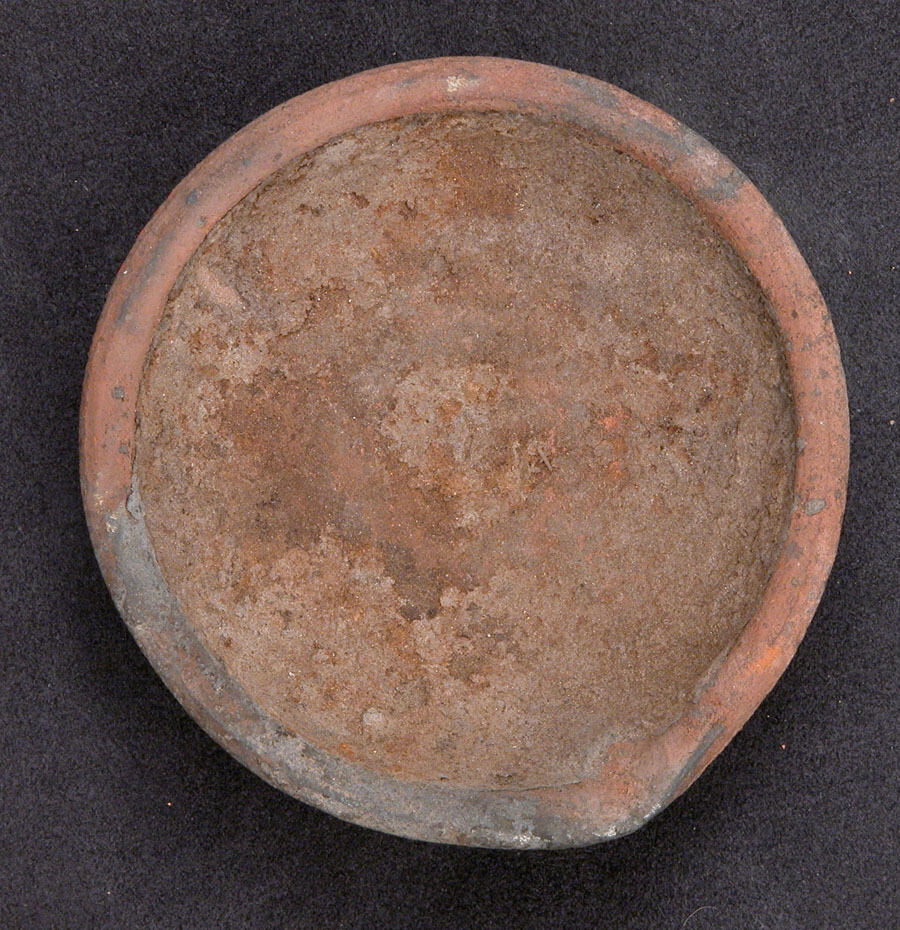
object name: lamp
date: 1-700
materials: earthenware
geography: egypt